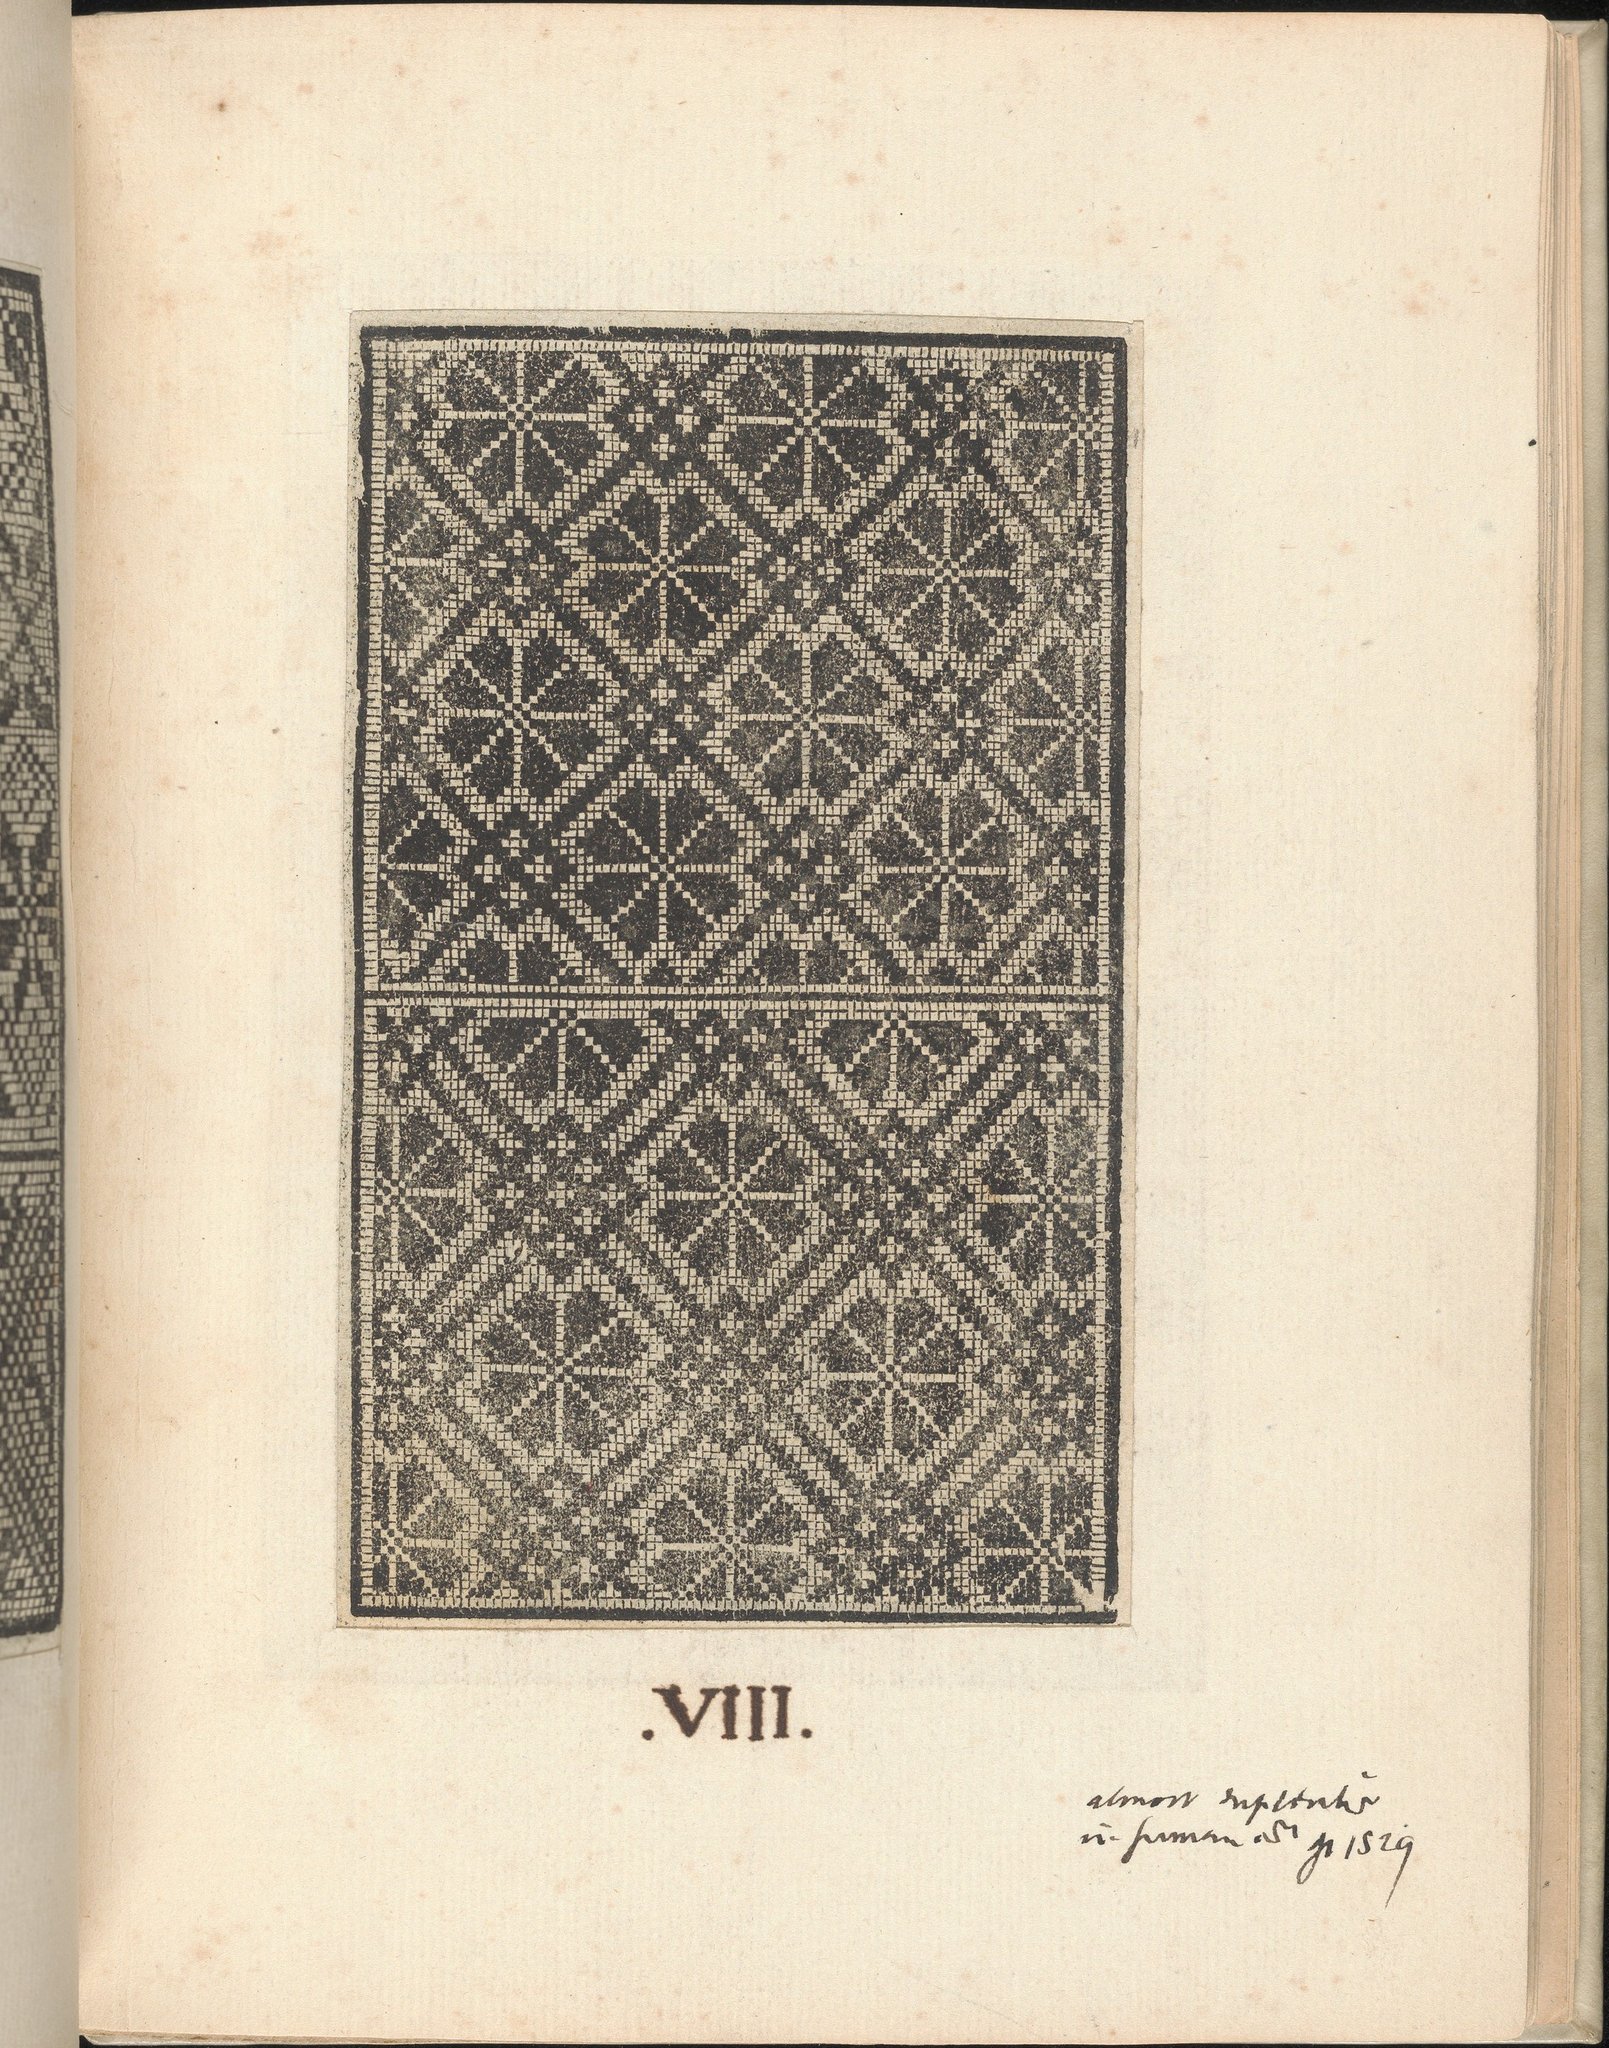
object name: book print ornament architecture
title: Esemplario di lavori, page 8 (recto)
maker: nicolò zoppino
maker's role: publisher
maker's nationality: italian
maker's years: 1478-1544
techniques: bookbinding, inlay, woodcut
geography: italy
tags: ornament